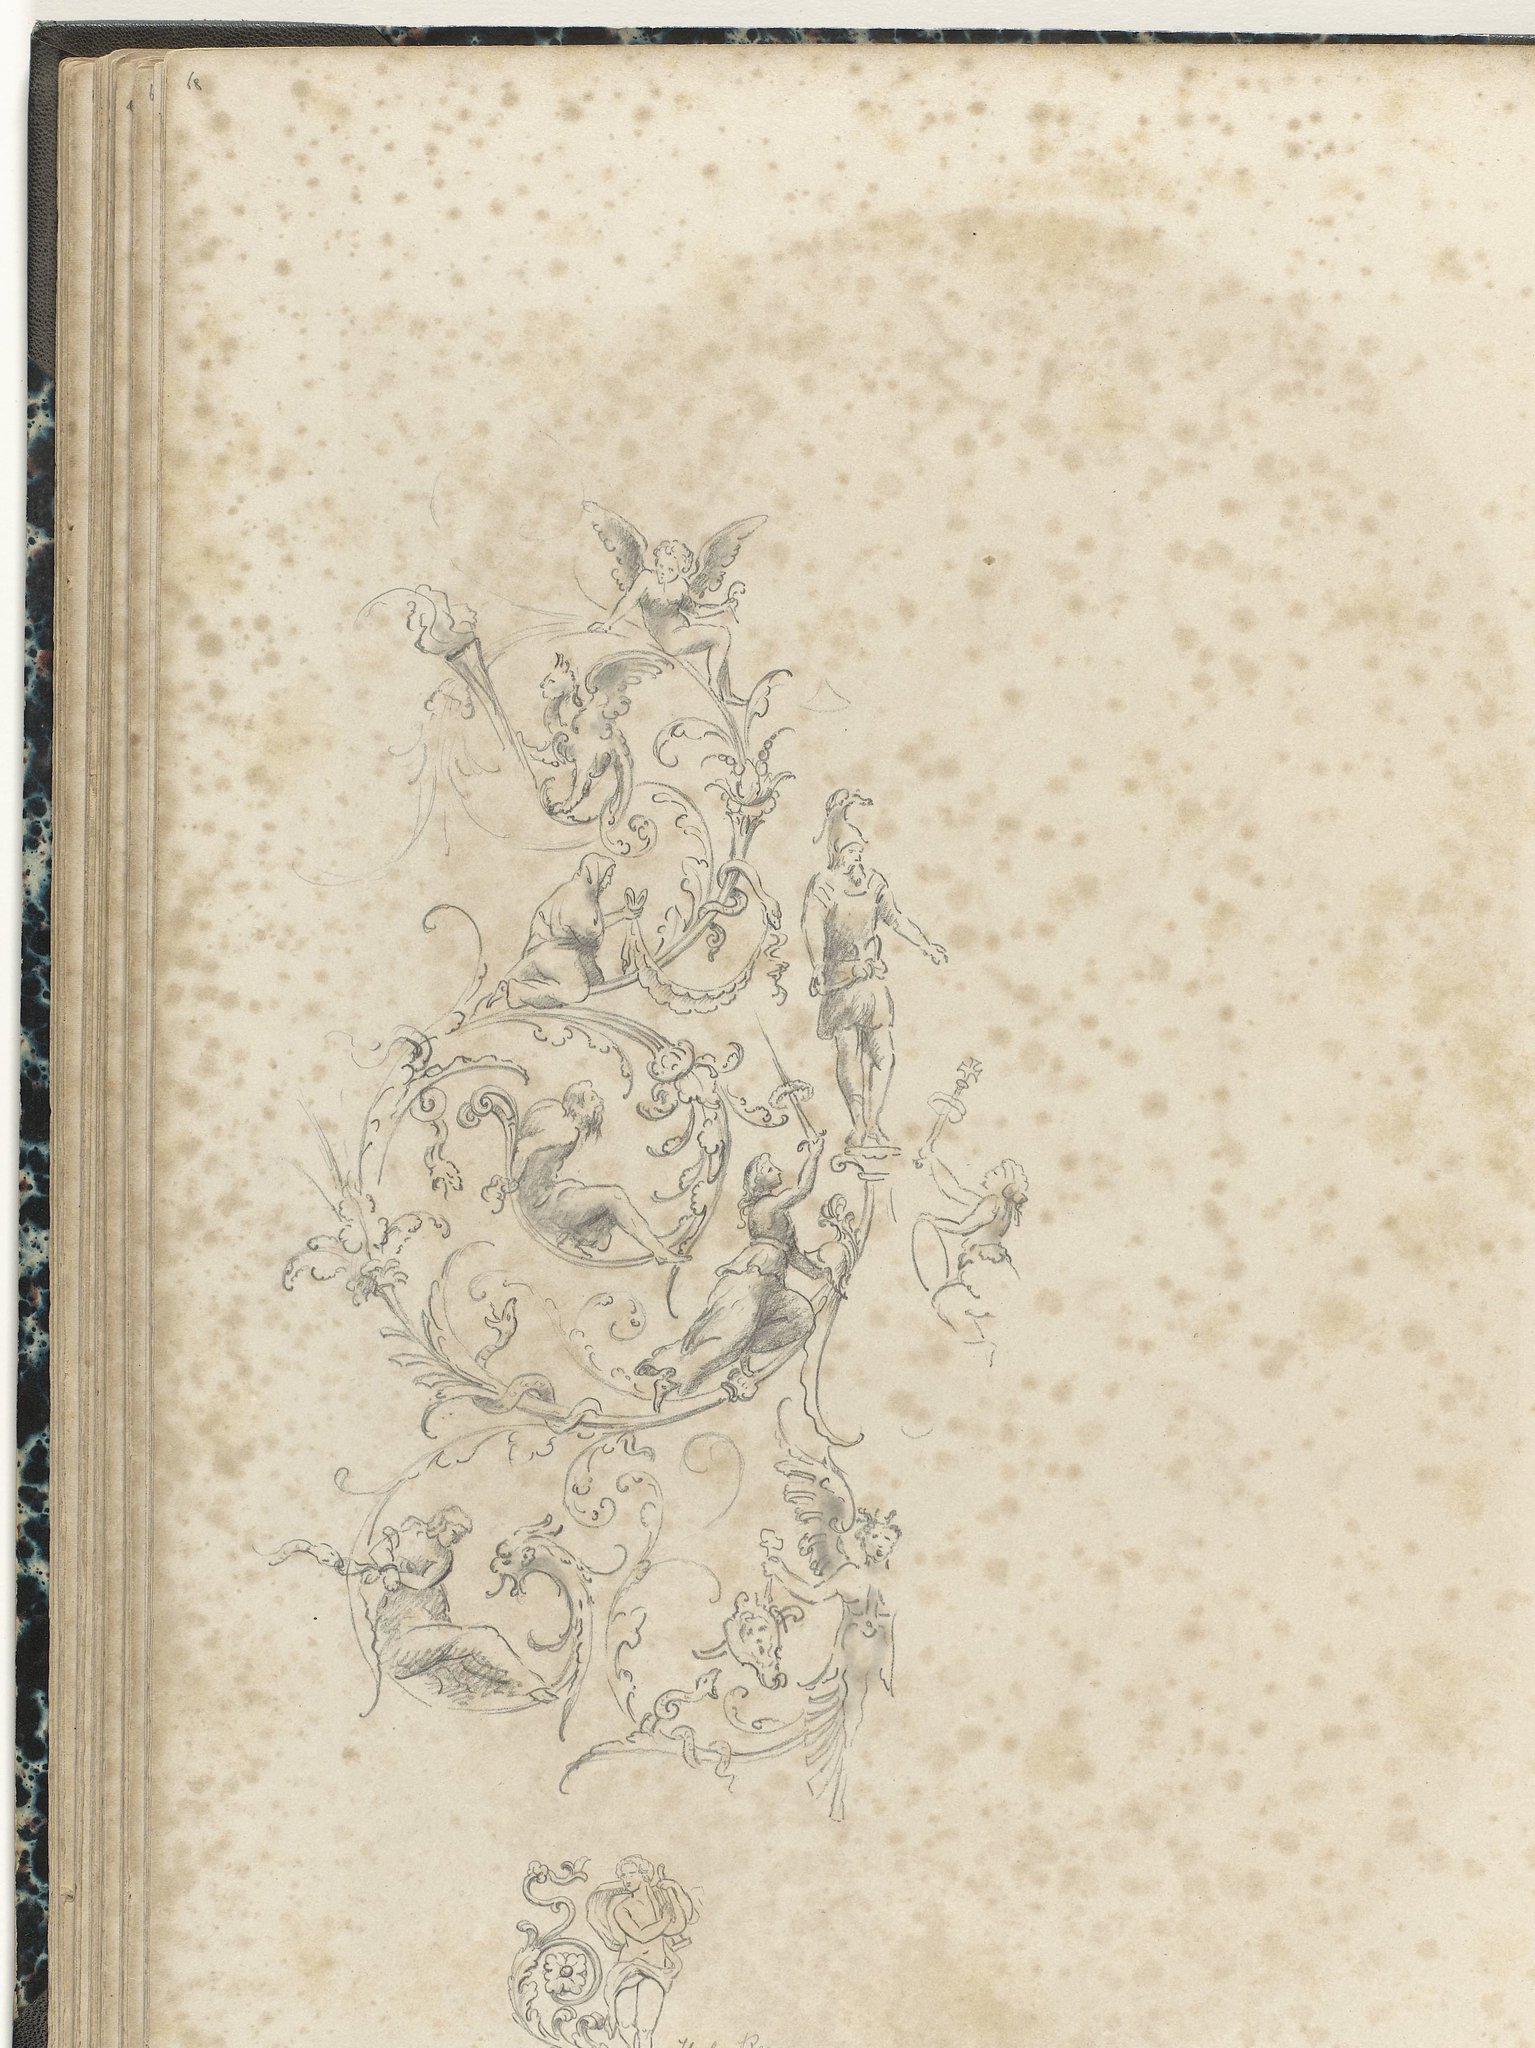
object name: drawing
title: Bladranken met figuren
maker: Anonymous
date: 1866-1900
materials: paper, pencil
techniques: drawing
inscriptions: annotation: ‘Ital. Ren.’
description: Bovenaan staat een bladrank afgebeeld waarop meerdere mensen en dieren zitten, onderaan staat een figuur op een bladrank die uitloopt in een gevleugelde leeuw.